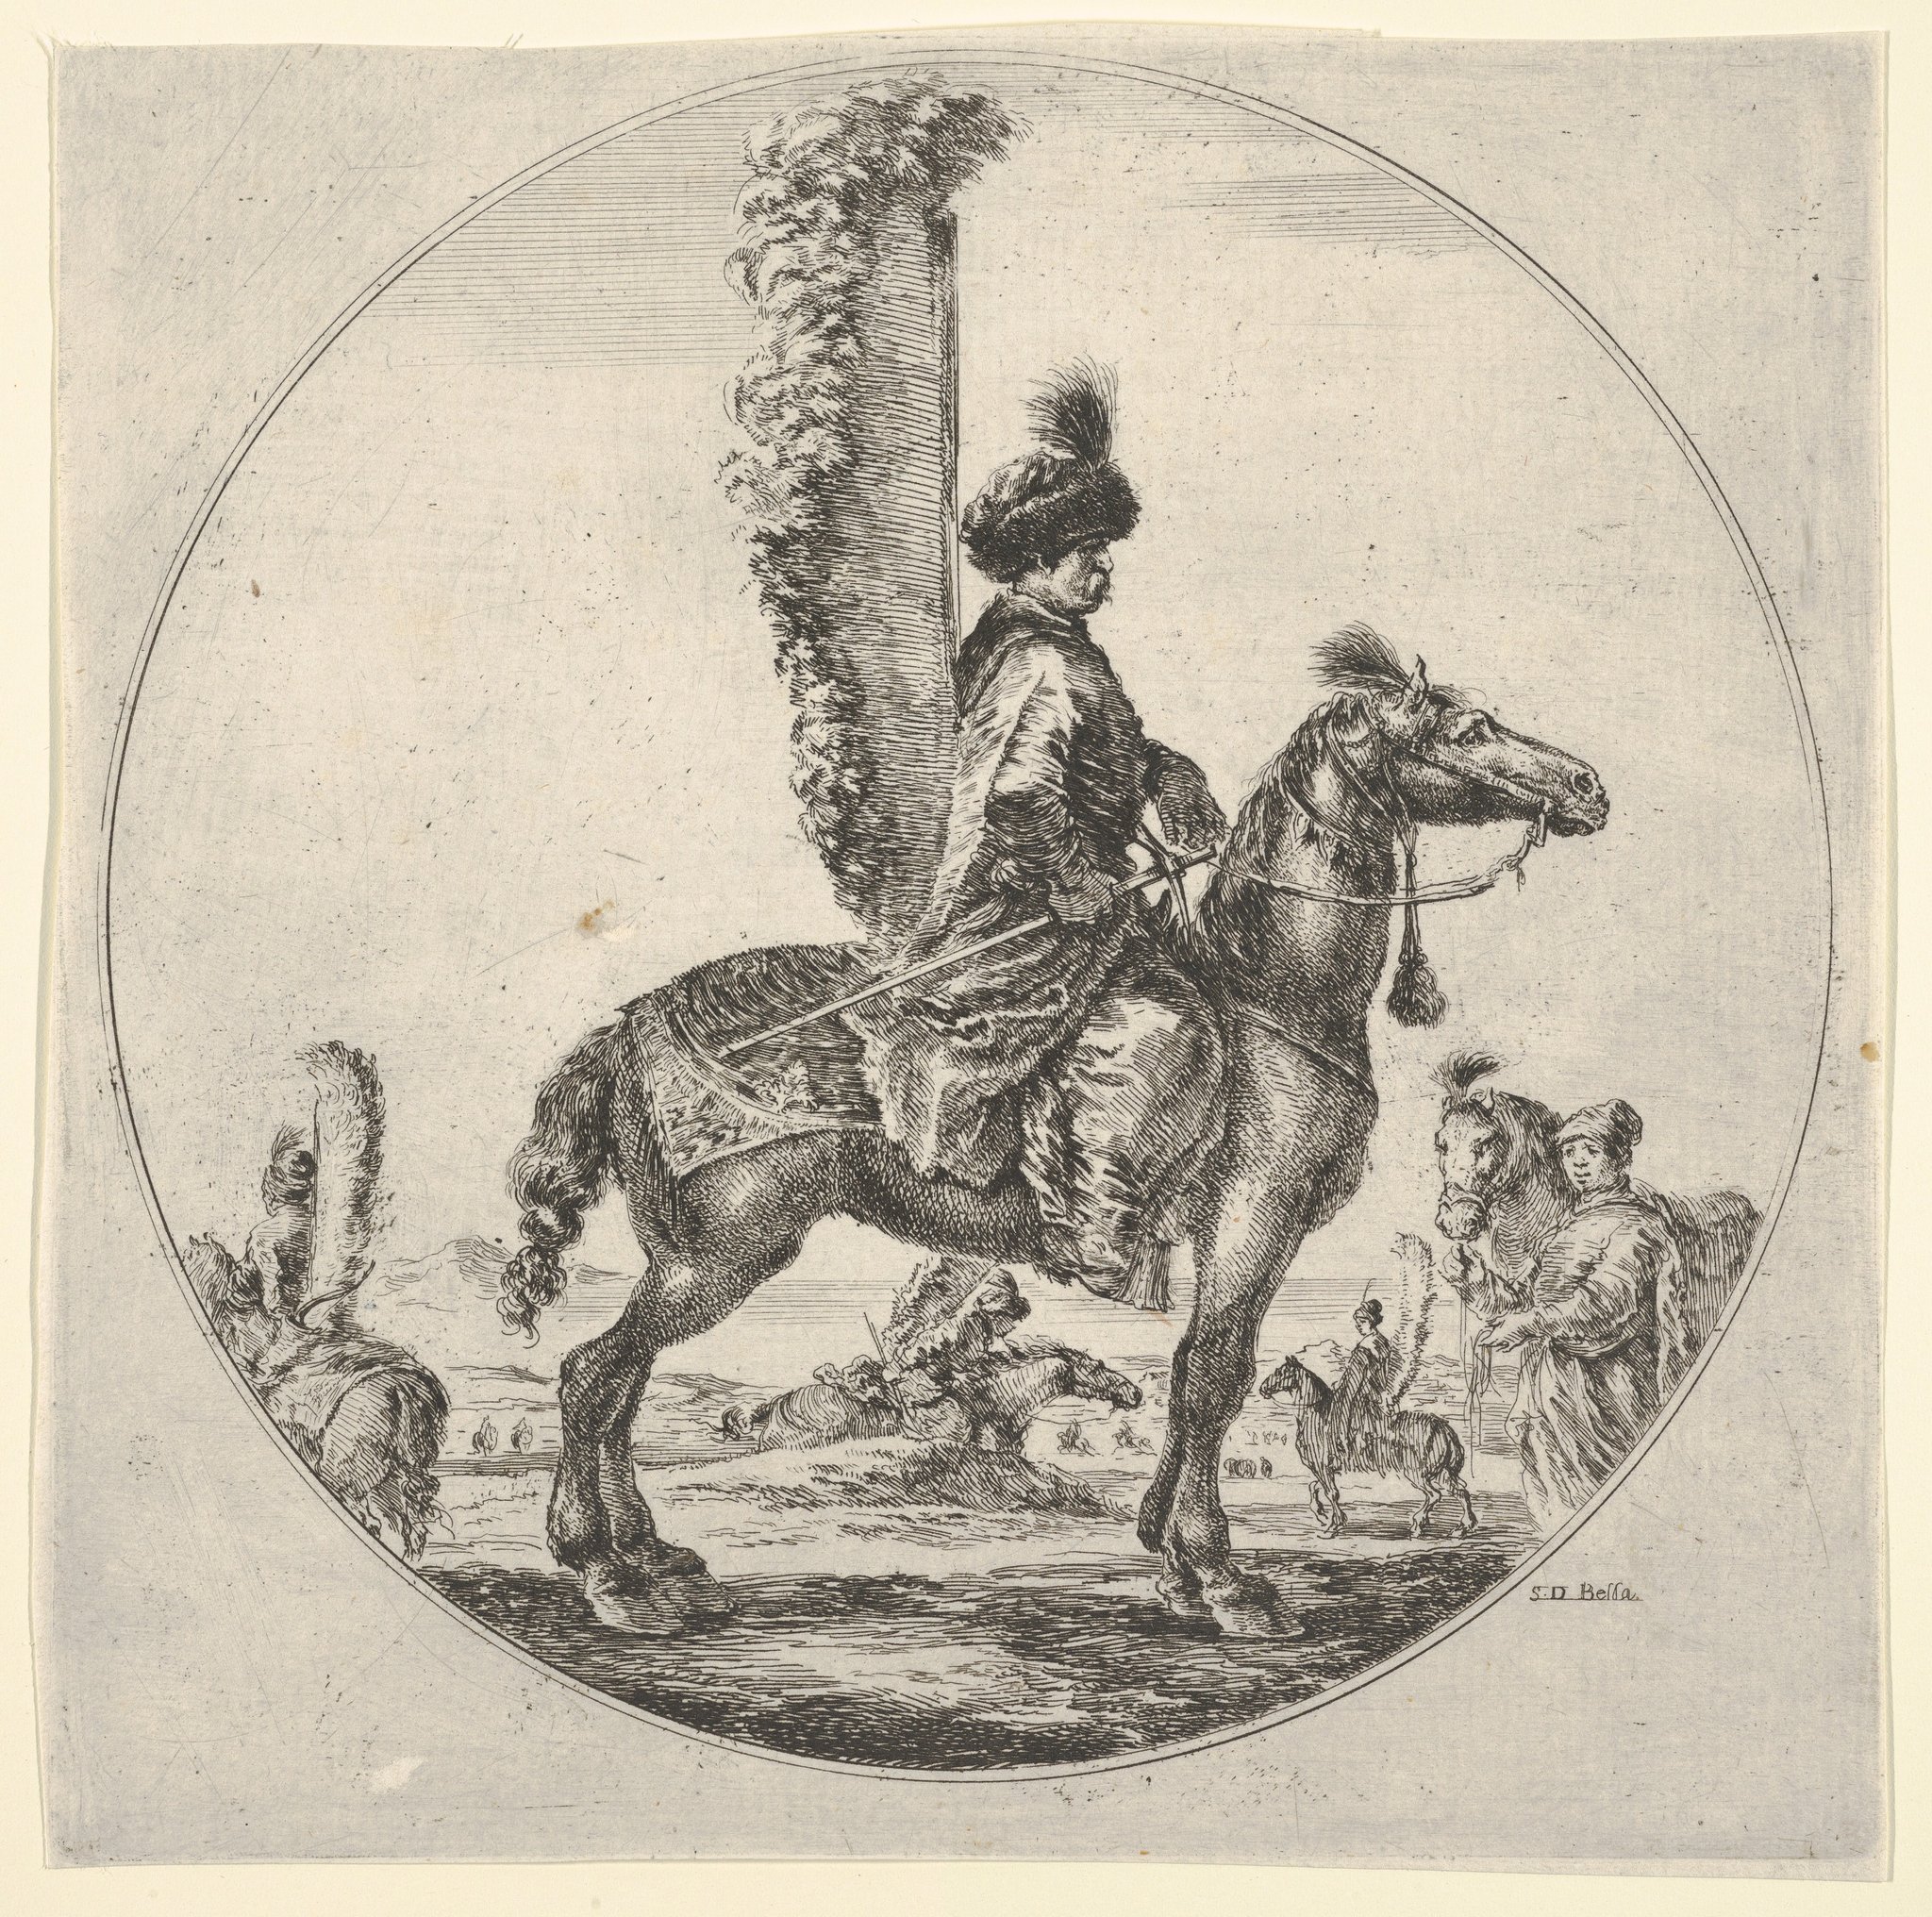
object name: print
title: Polish hussar in profile facing right with wings attached to his back, a circular composition, from "Figures on Horseback" (Cavaliers nègres, polonais et hongrois)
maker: stefano della bella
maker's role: artist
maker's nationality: italian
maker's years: 1610-1664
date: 1648-1653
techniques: etching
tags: men,profiles,horses